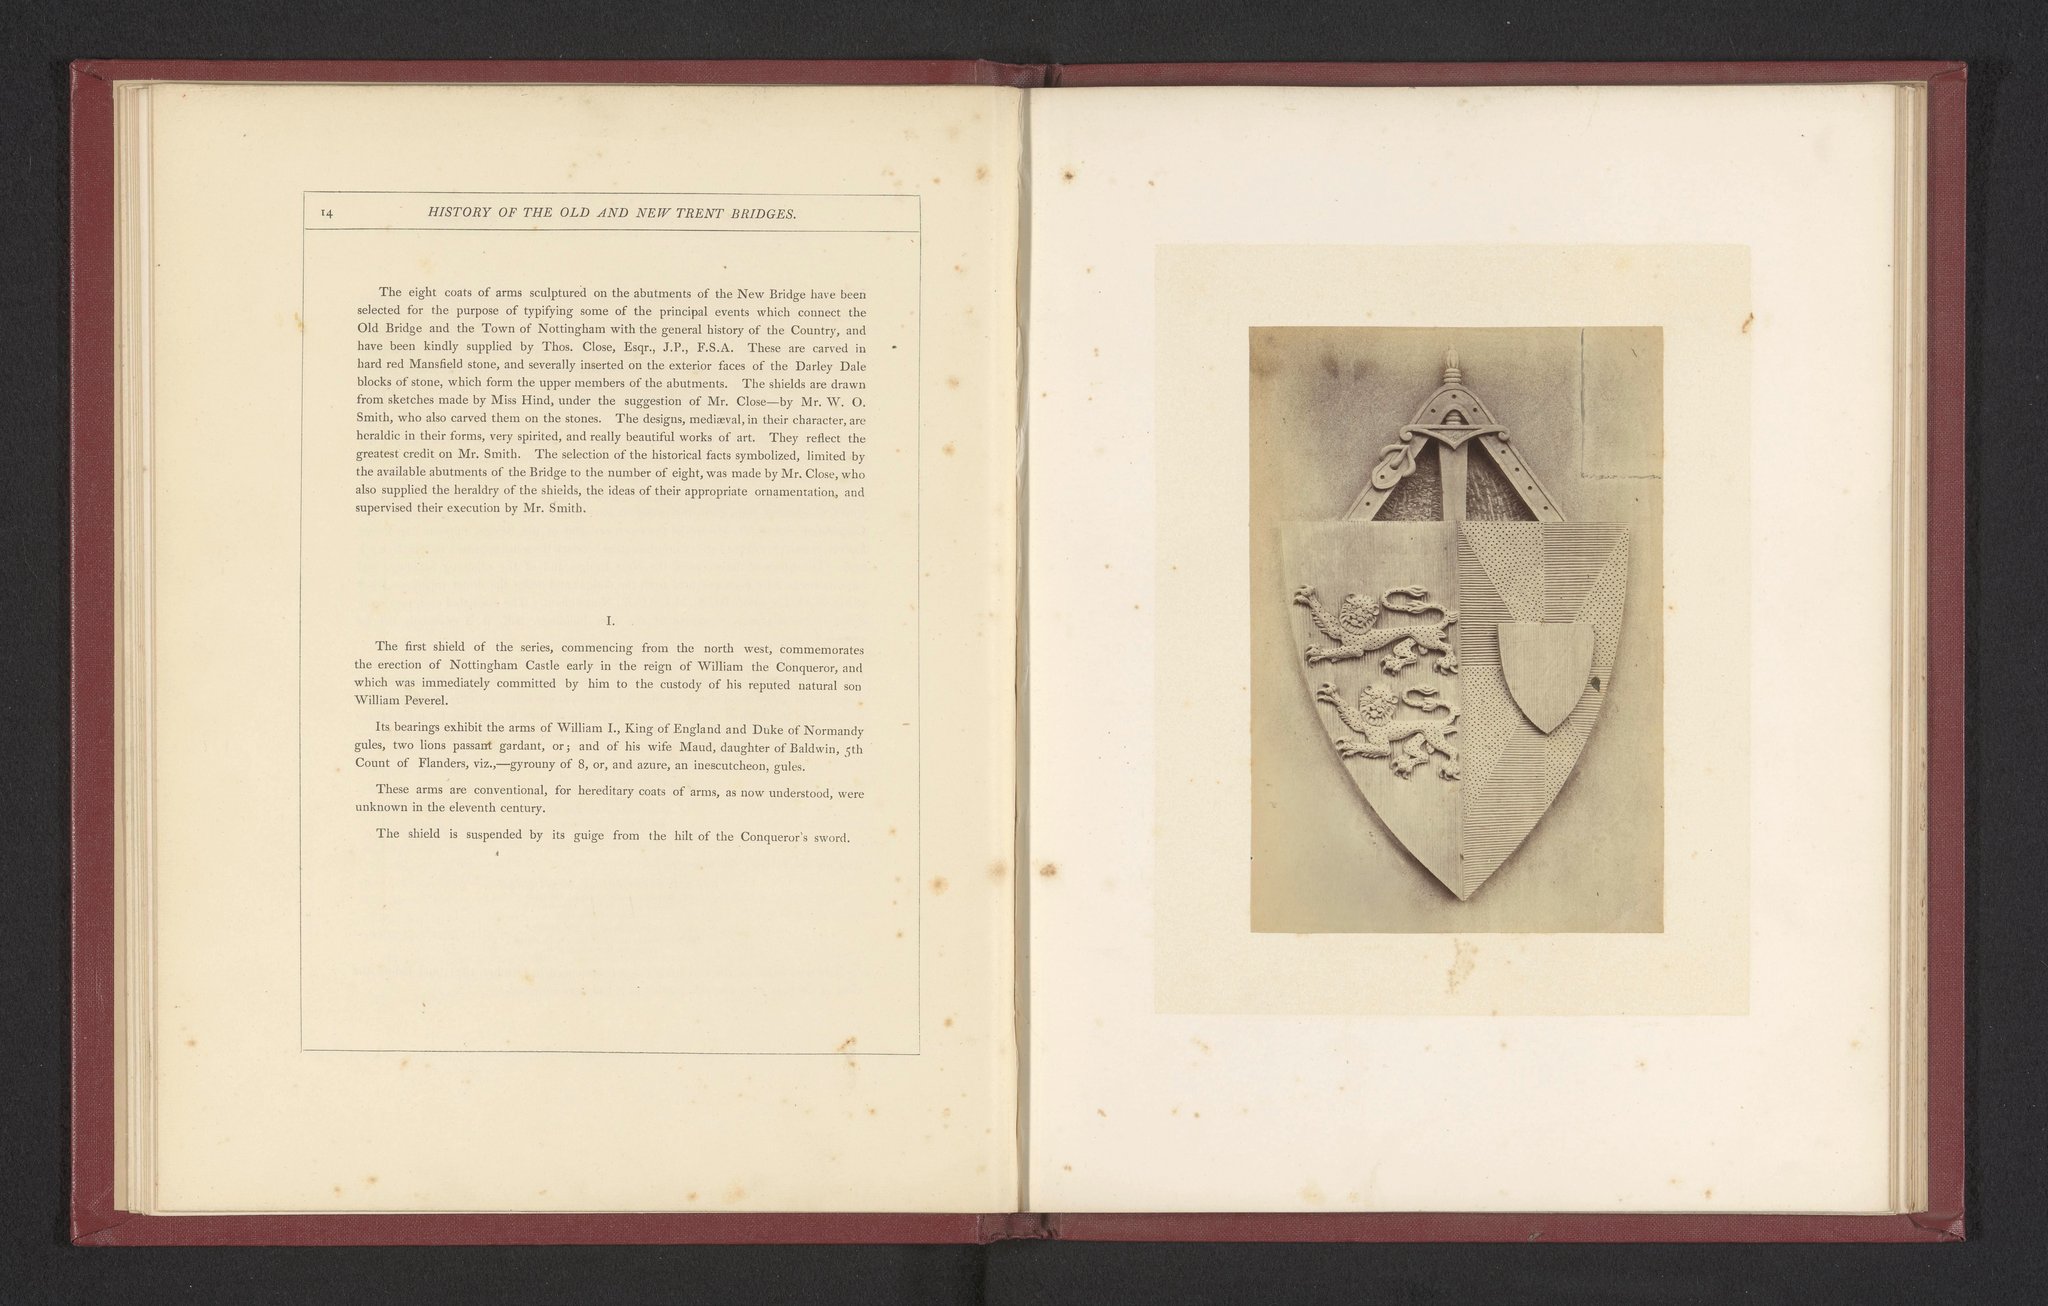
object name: page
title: Wapenschild met de tekens van Willem I en zijn vrouw op de Trent Bridge in Nottingham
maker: Anonymous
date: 1871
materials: photographic support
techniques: albumen print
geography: nottingham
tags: coat of arms (as symbol of the state, etc.), bridge in city across river, canal, etc.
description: Links twee leeuwen, rechts een schild, boven een zwaard.